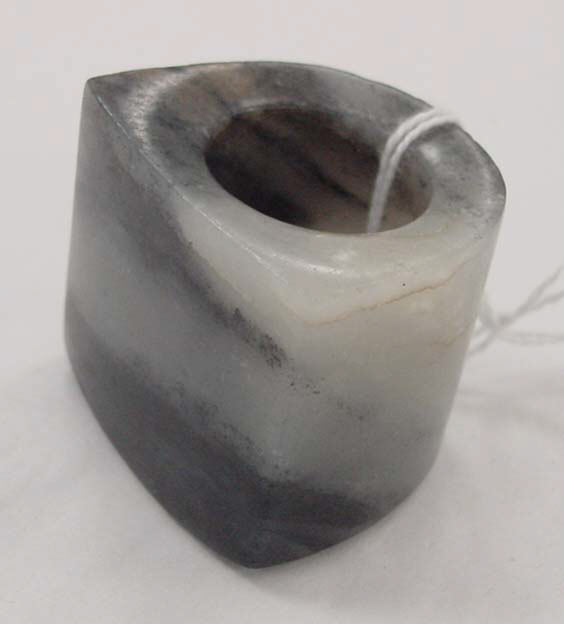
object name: ring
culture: chinese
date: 1801-1900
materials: jade